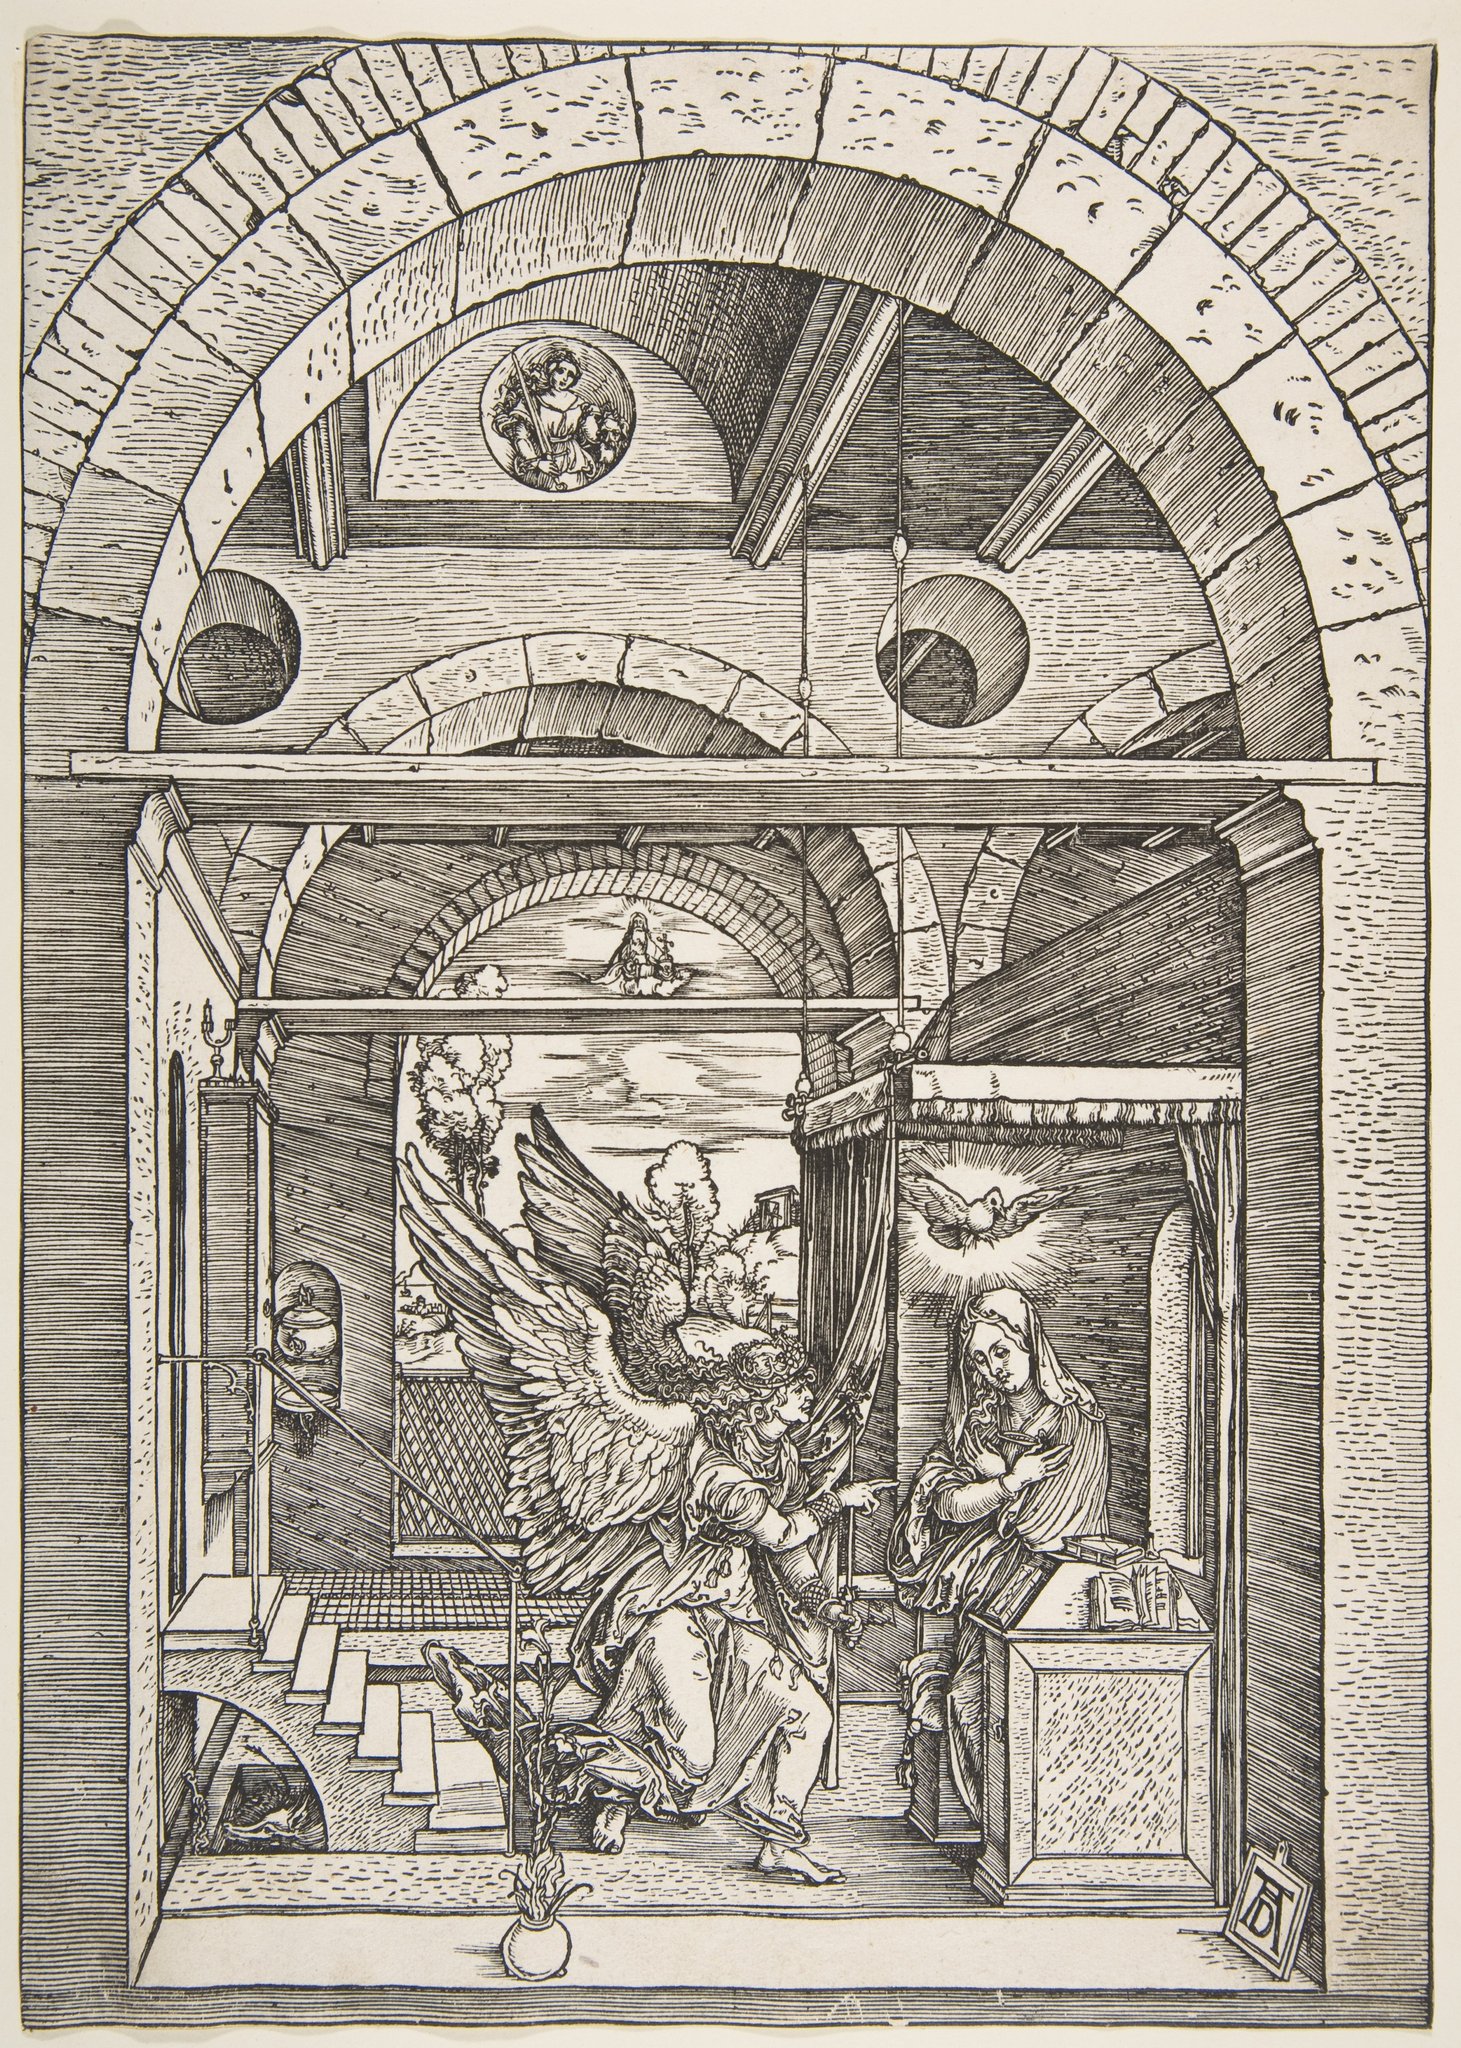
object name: print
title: The Annunciation, from "The Life of the Virgin"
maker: albrecht dürer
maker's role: artist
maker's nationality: german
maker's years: 1471-1528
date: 1503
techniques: woodcut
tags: birds,angels,virgin mary,annunciation